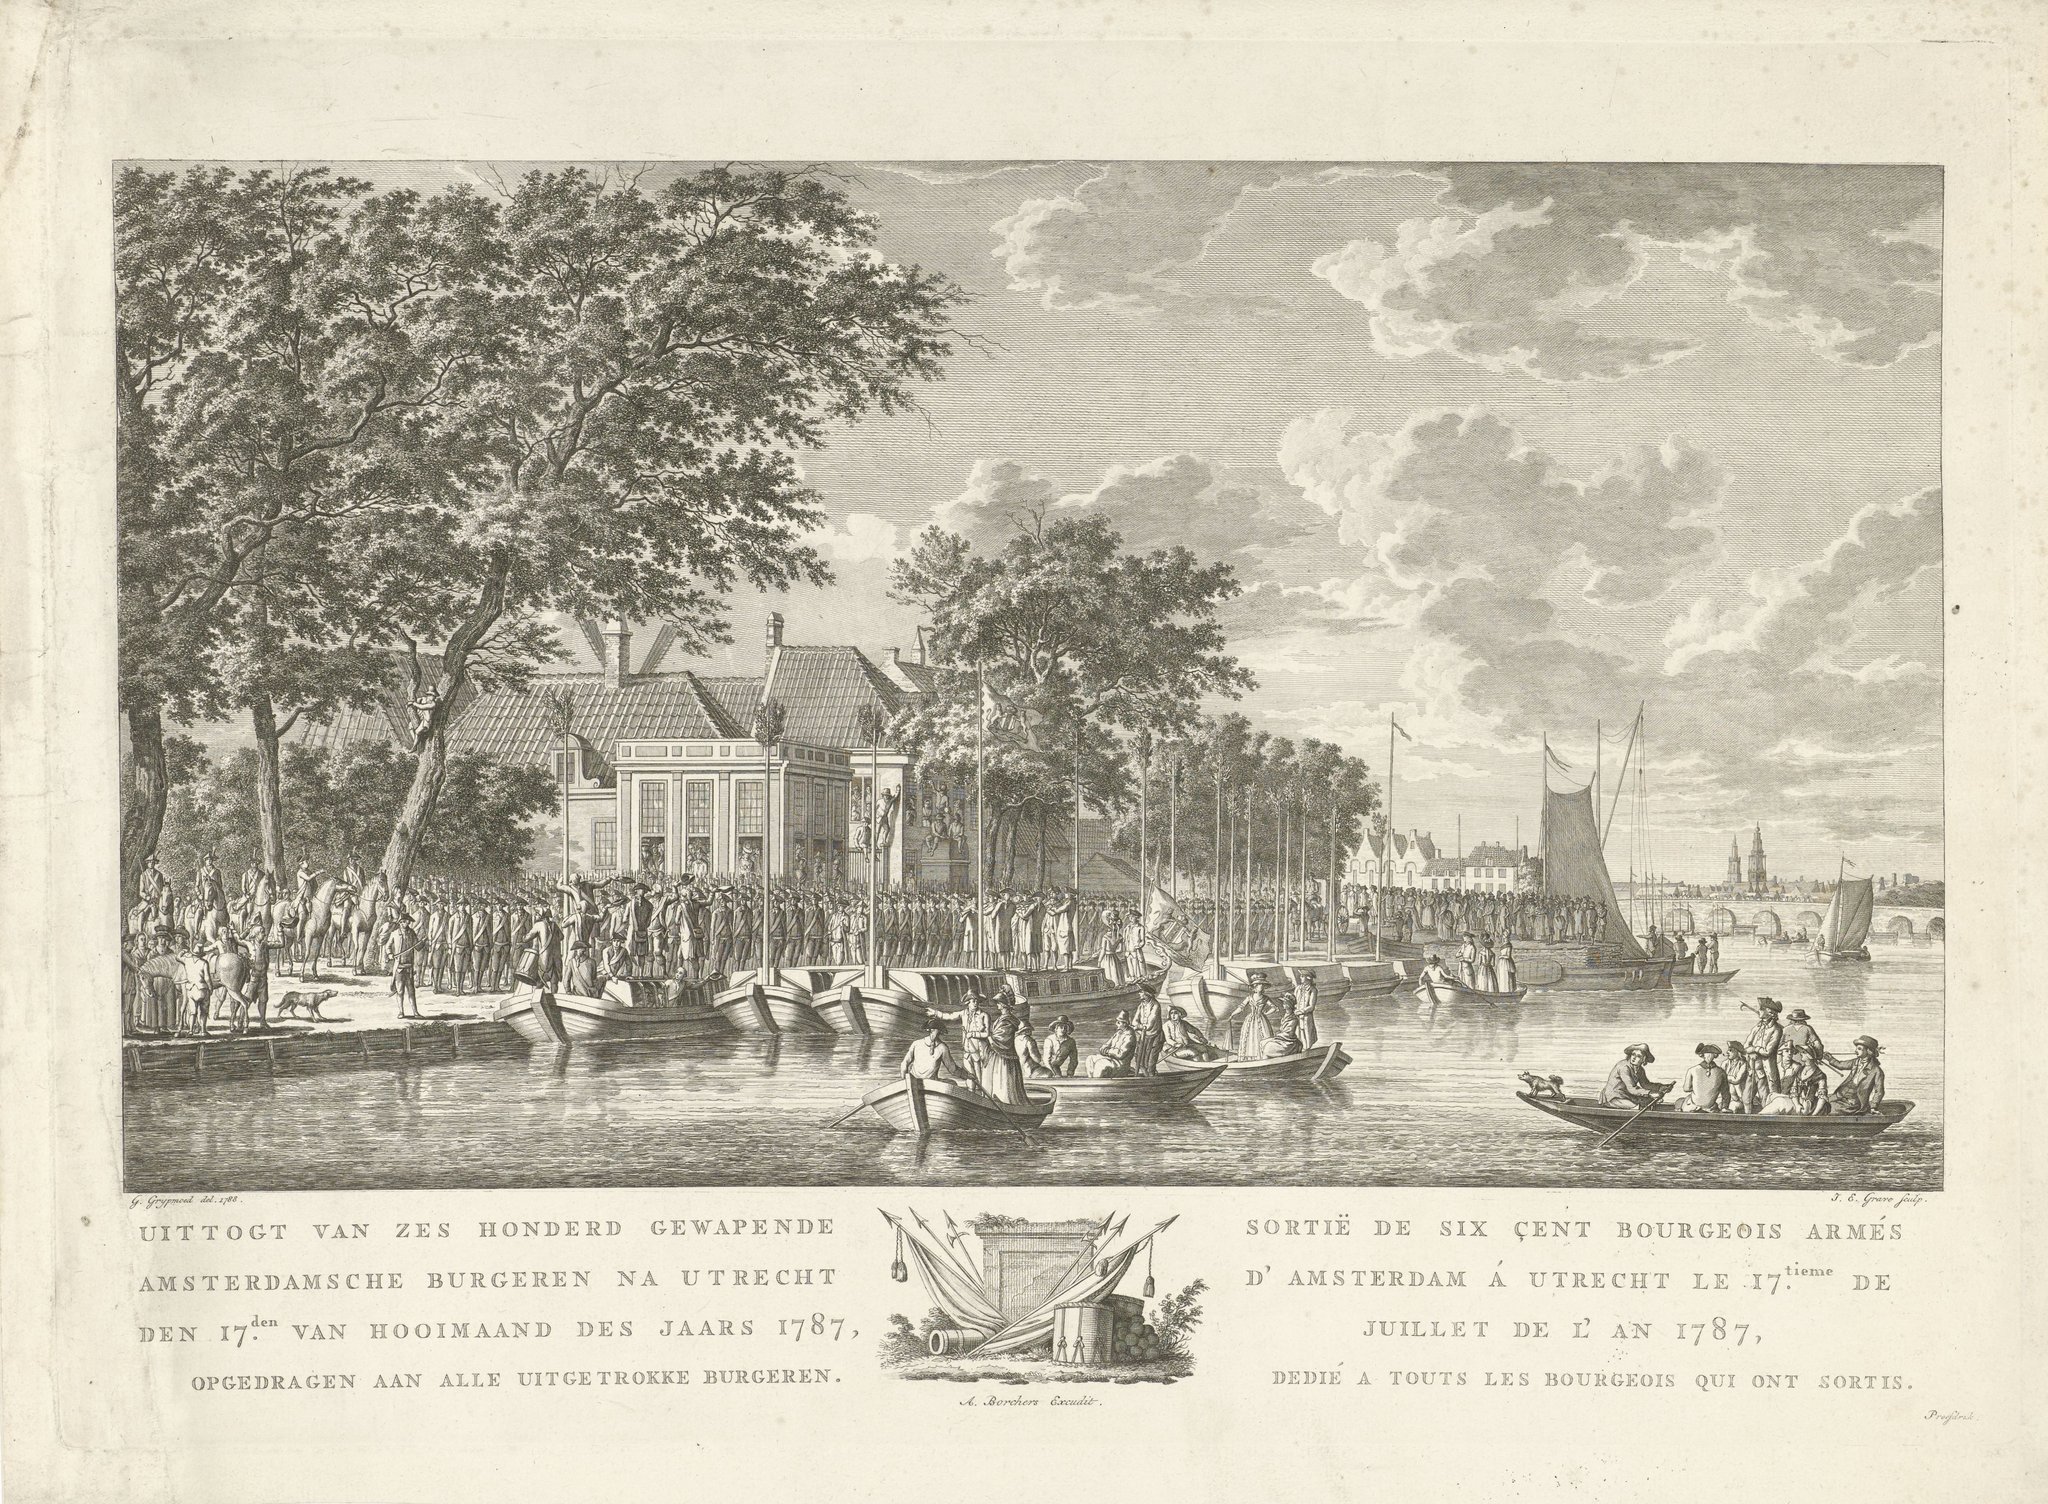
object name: print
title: Uittogt van zes honderd gewapende Amsterdamsche Burgeren na Utrecht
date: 1788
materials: paper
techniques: engraving, etching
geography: amsterdam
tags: patriots (1780-1795)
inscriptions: collector's mark: Lugt 2233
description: Onder het toeziend oog van het toegestroomd publiek bij herberg de Berebijt vertrekken zeshonderd Amsterdamse burgers op 17 juli 1787 uit Amsterdam naar Utrecht, om daar het patriottenleger aan te vullen. De prent heeft een Nederlands en Frans onderschrift.